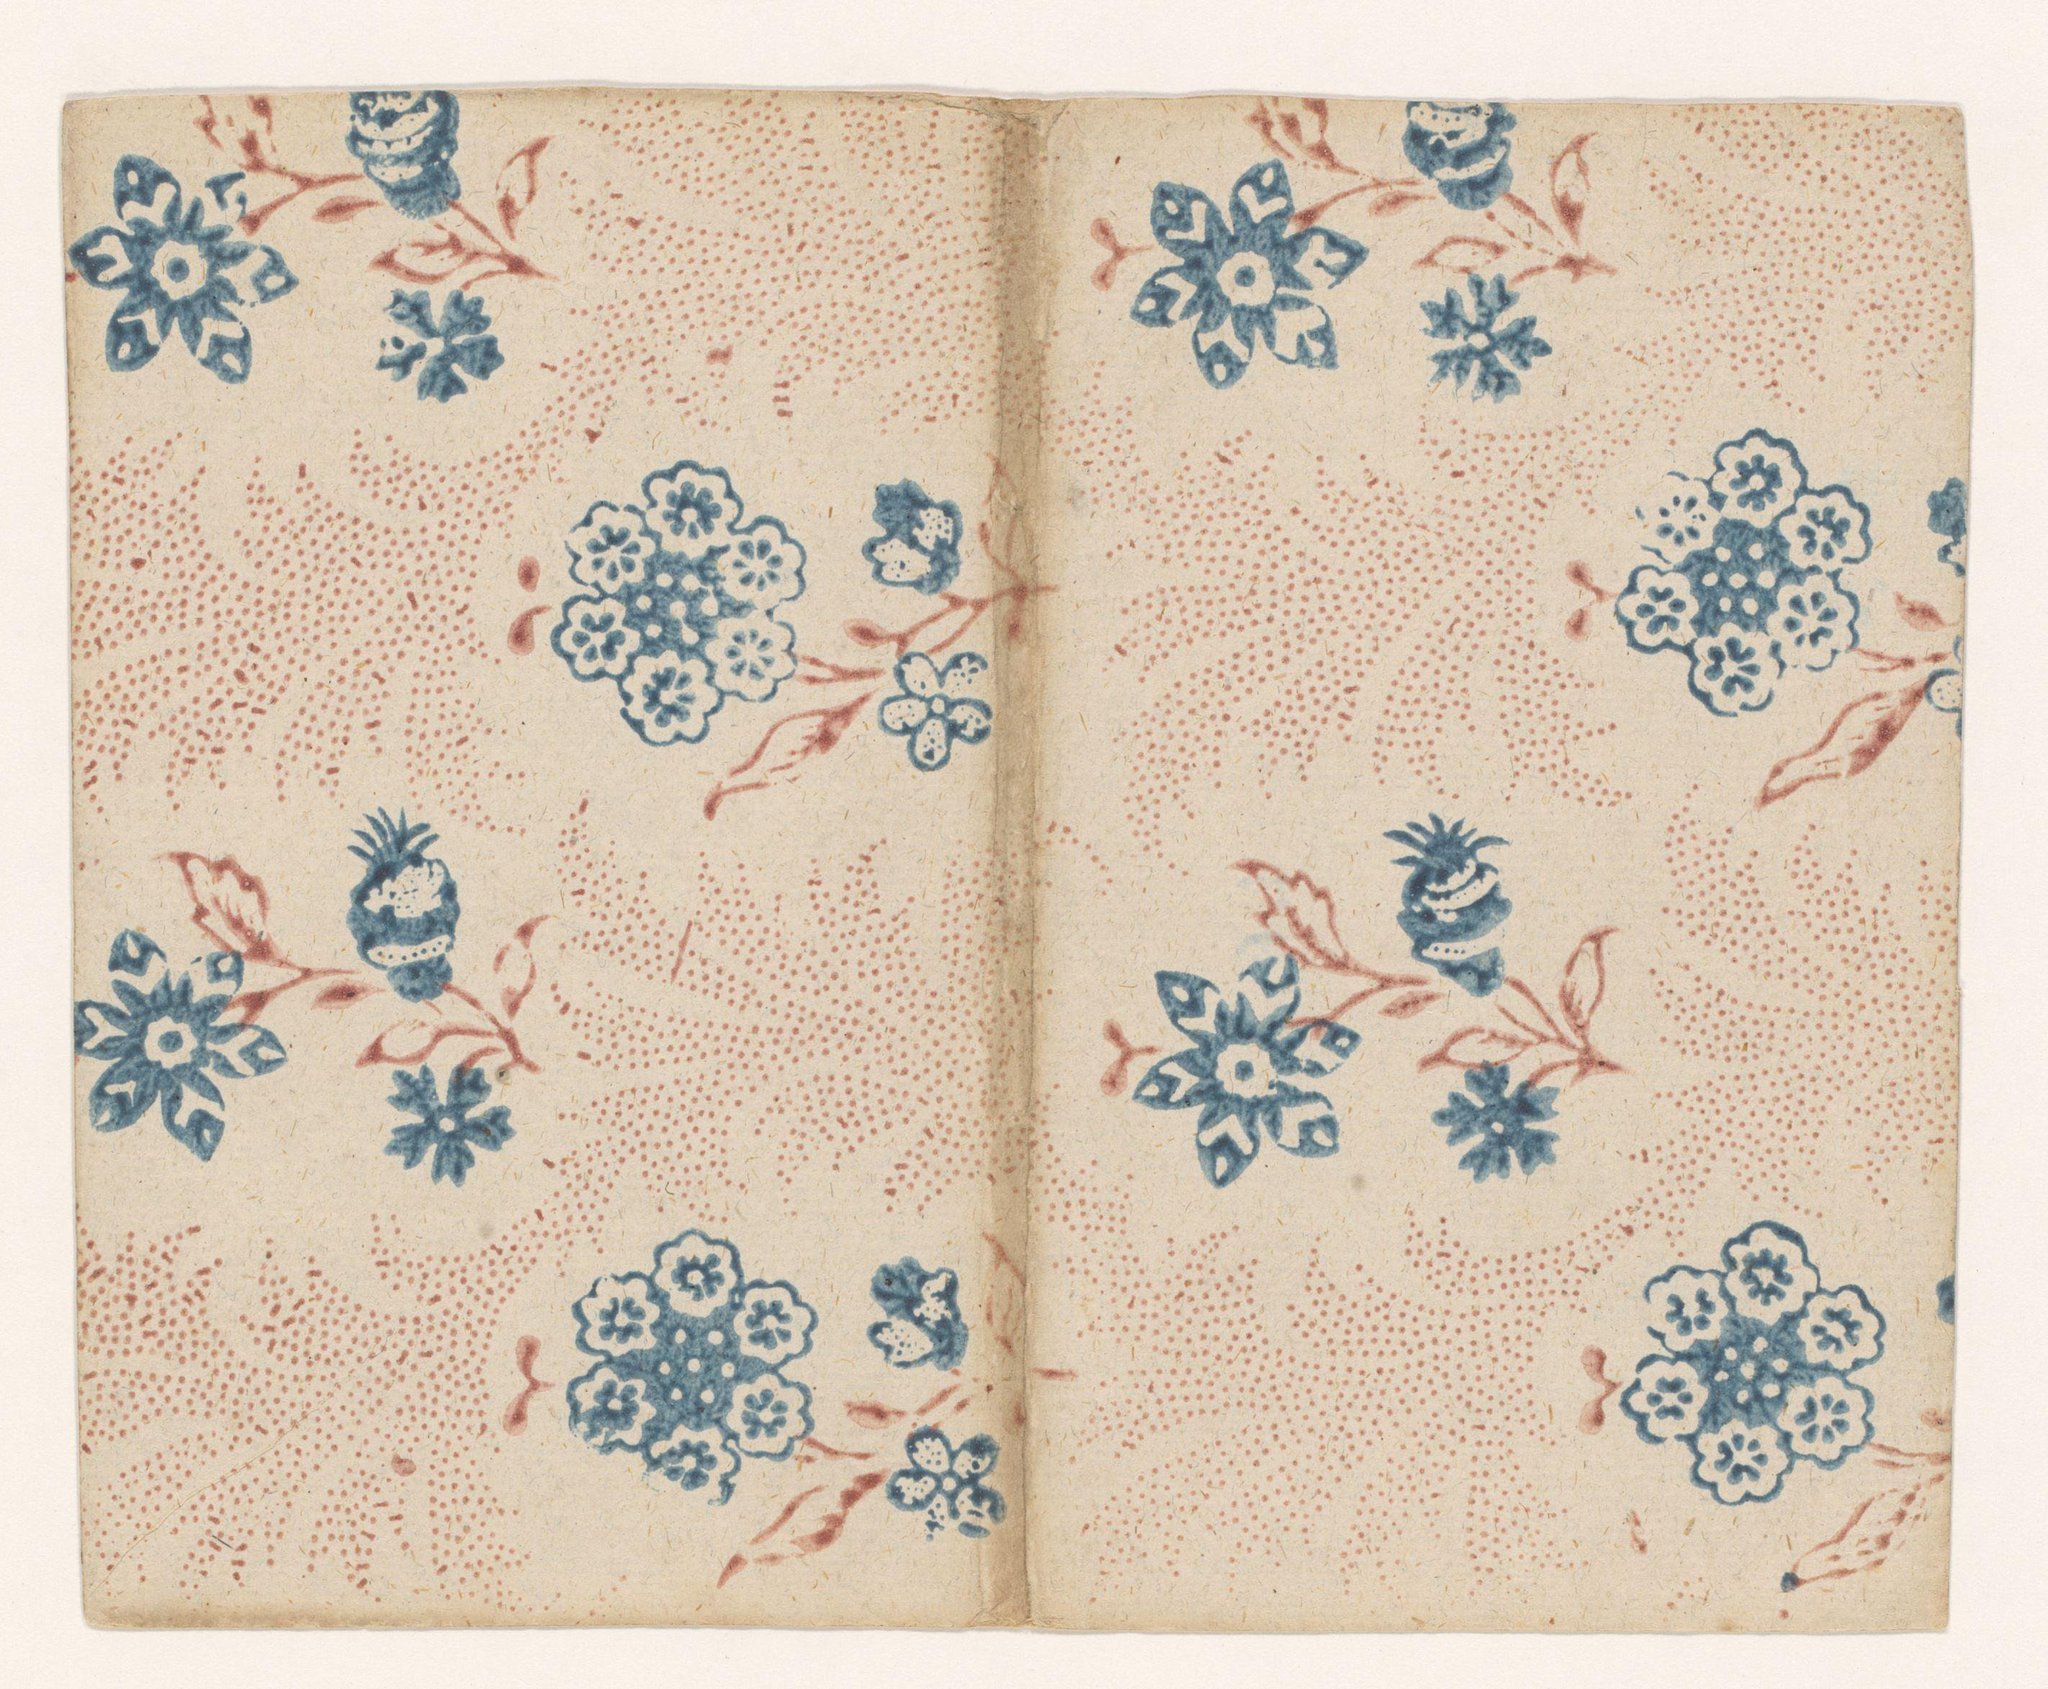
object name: wrapper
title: Blad met strooipatroon van bloemen tussen ranken van punten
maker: Anonymous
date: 1700-1850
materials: paper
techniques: printing block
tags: ornament derived from plant forms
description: Blad met strooipatroon van bloemen tussen ranken van punten. Gebruikt als omslag.